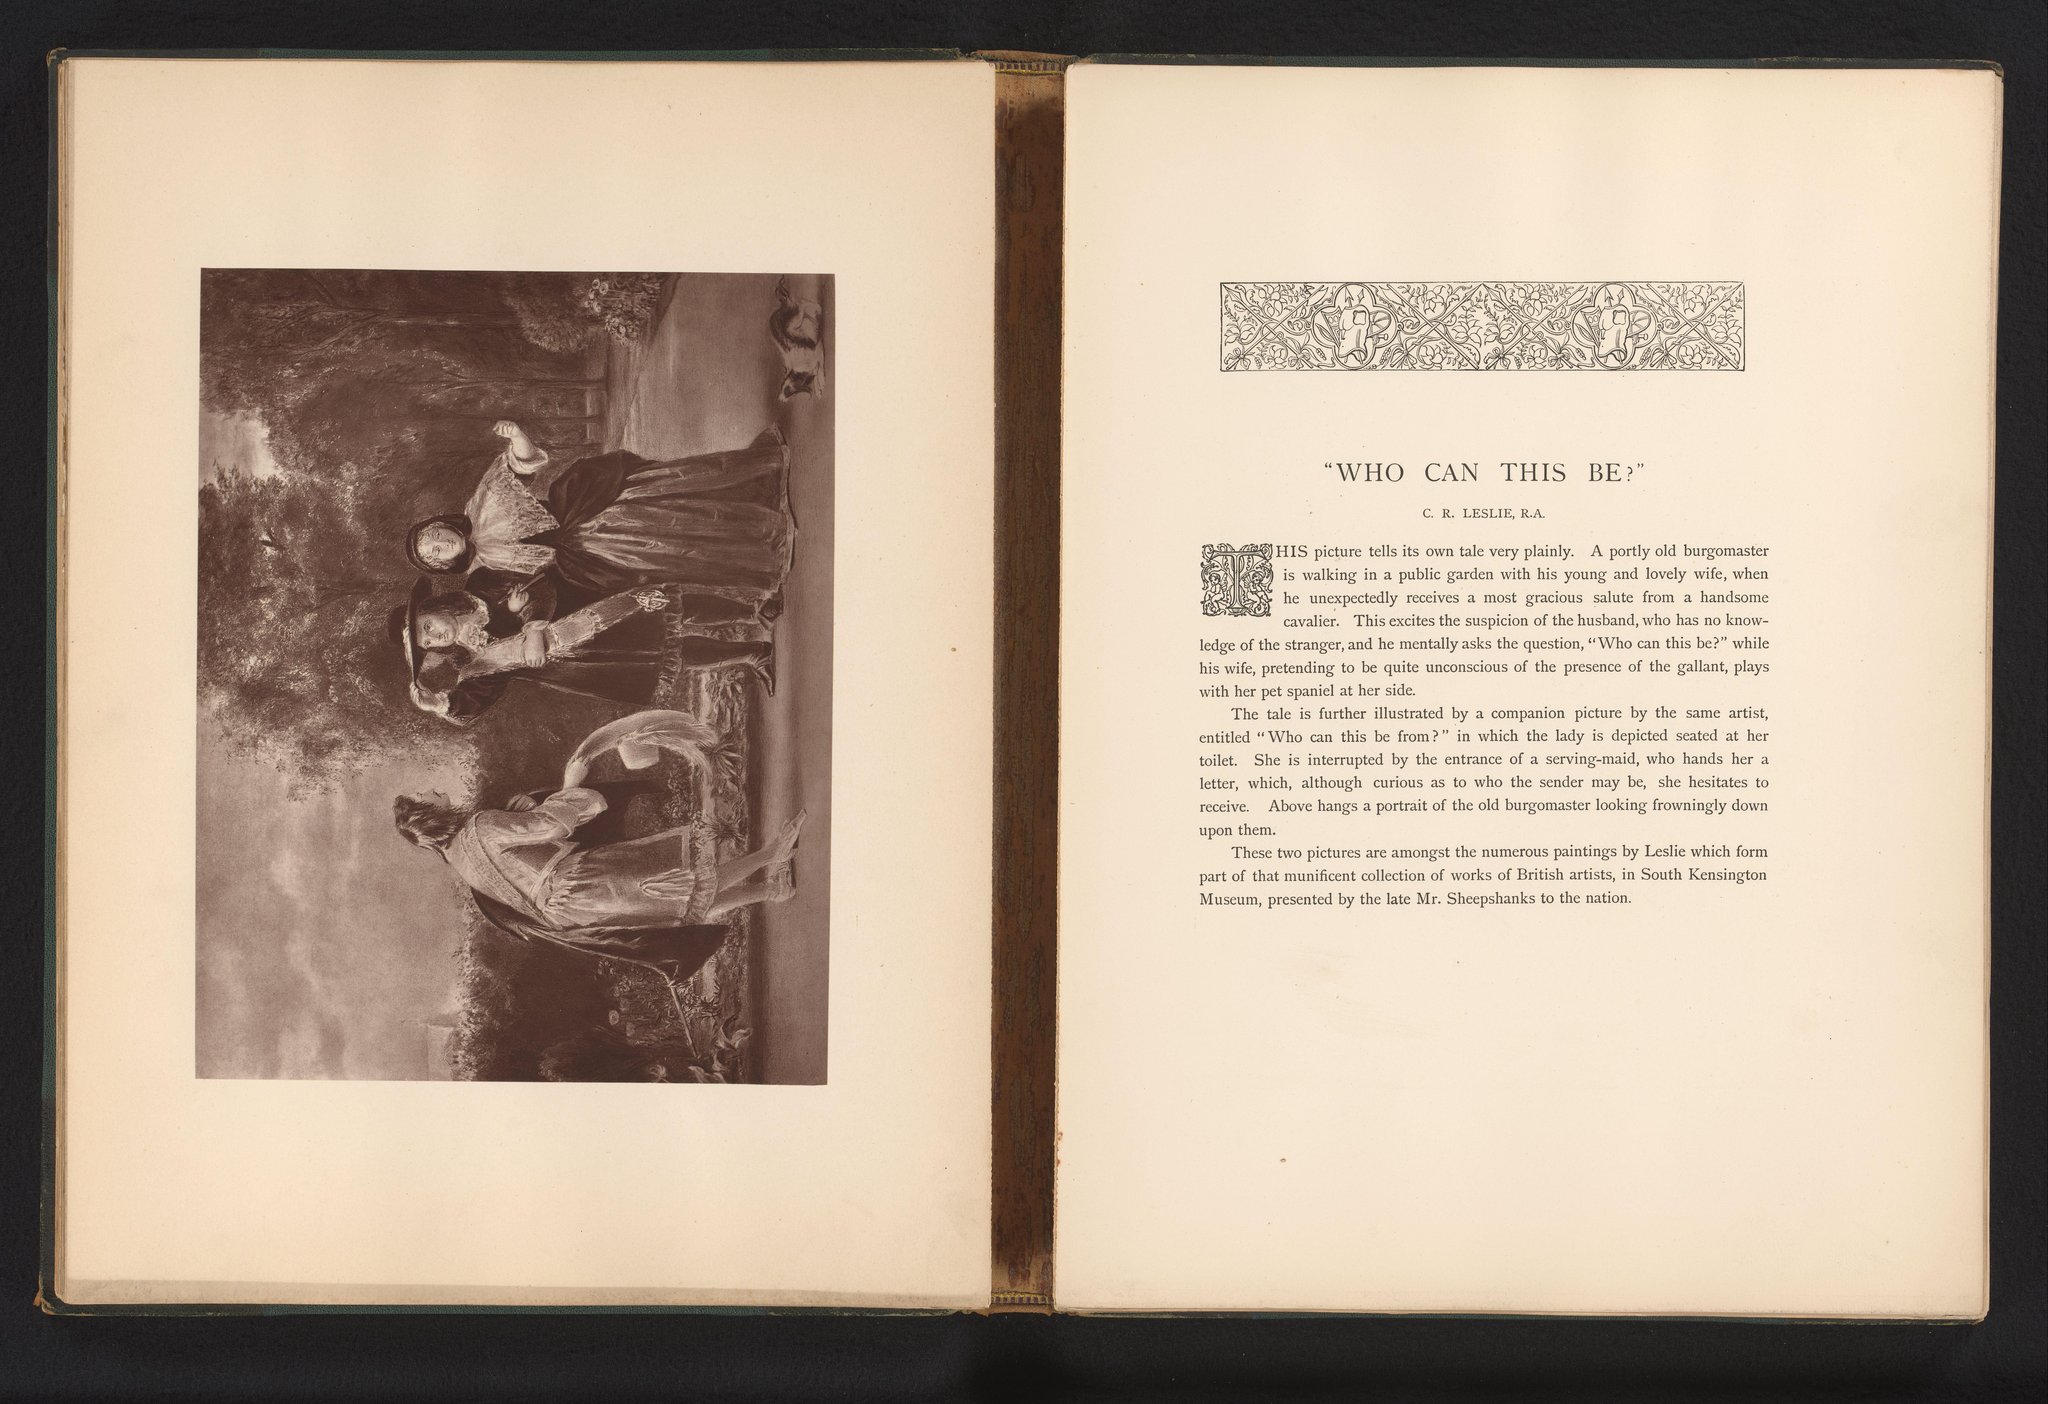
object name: reproduction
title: Reproductie van een schilderij van een man en vrouw die worden gegroet door een onbekende man door Charles Robert Leslie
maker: Anonymous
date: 1874-1879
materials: paper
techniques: woodburytype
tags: baring the head, lifting one's hat, marriage, married couple, 'matrimonium'